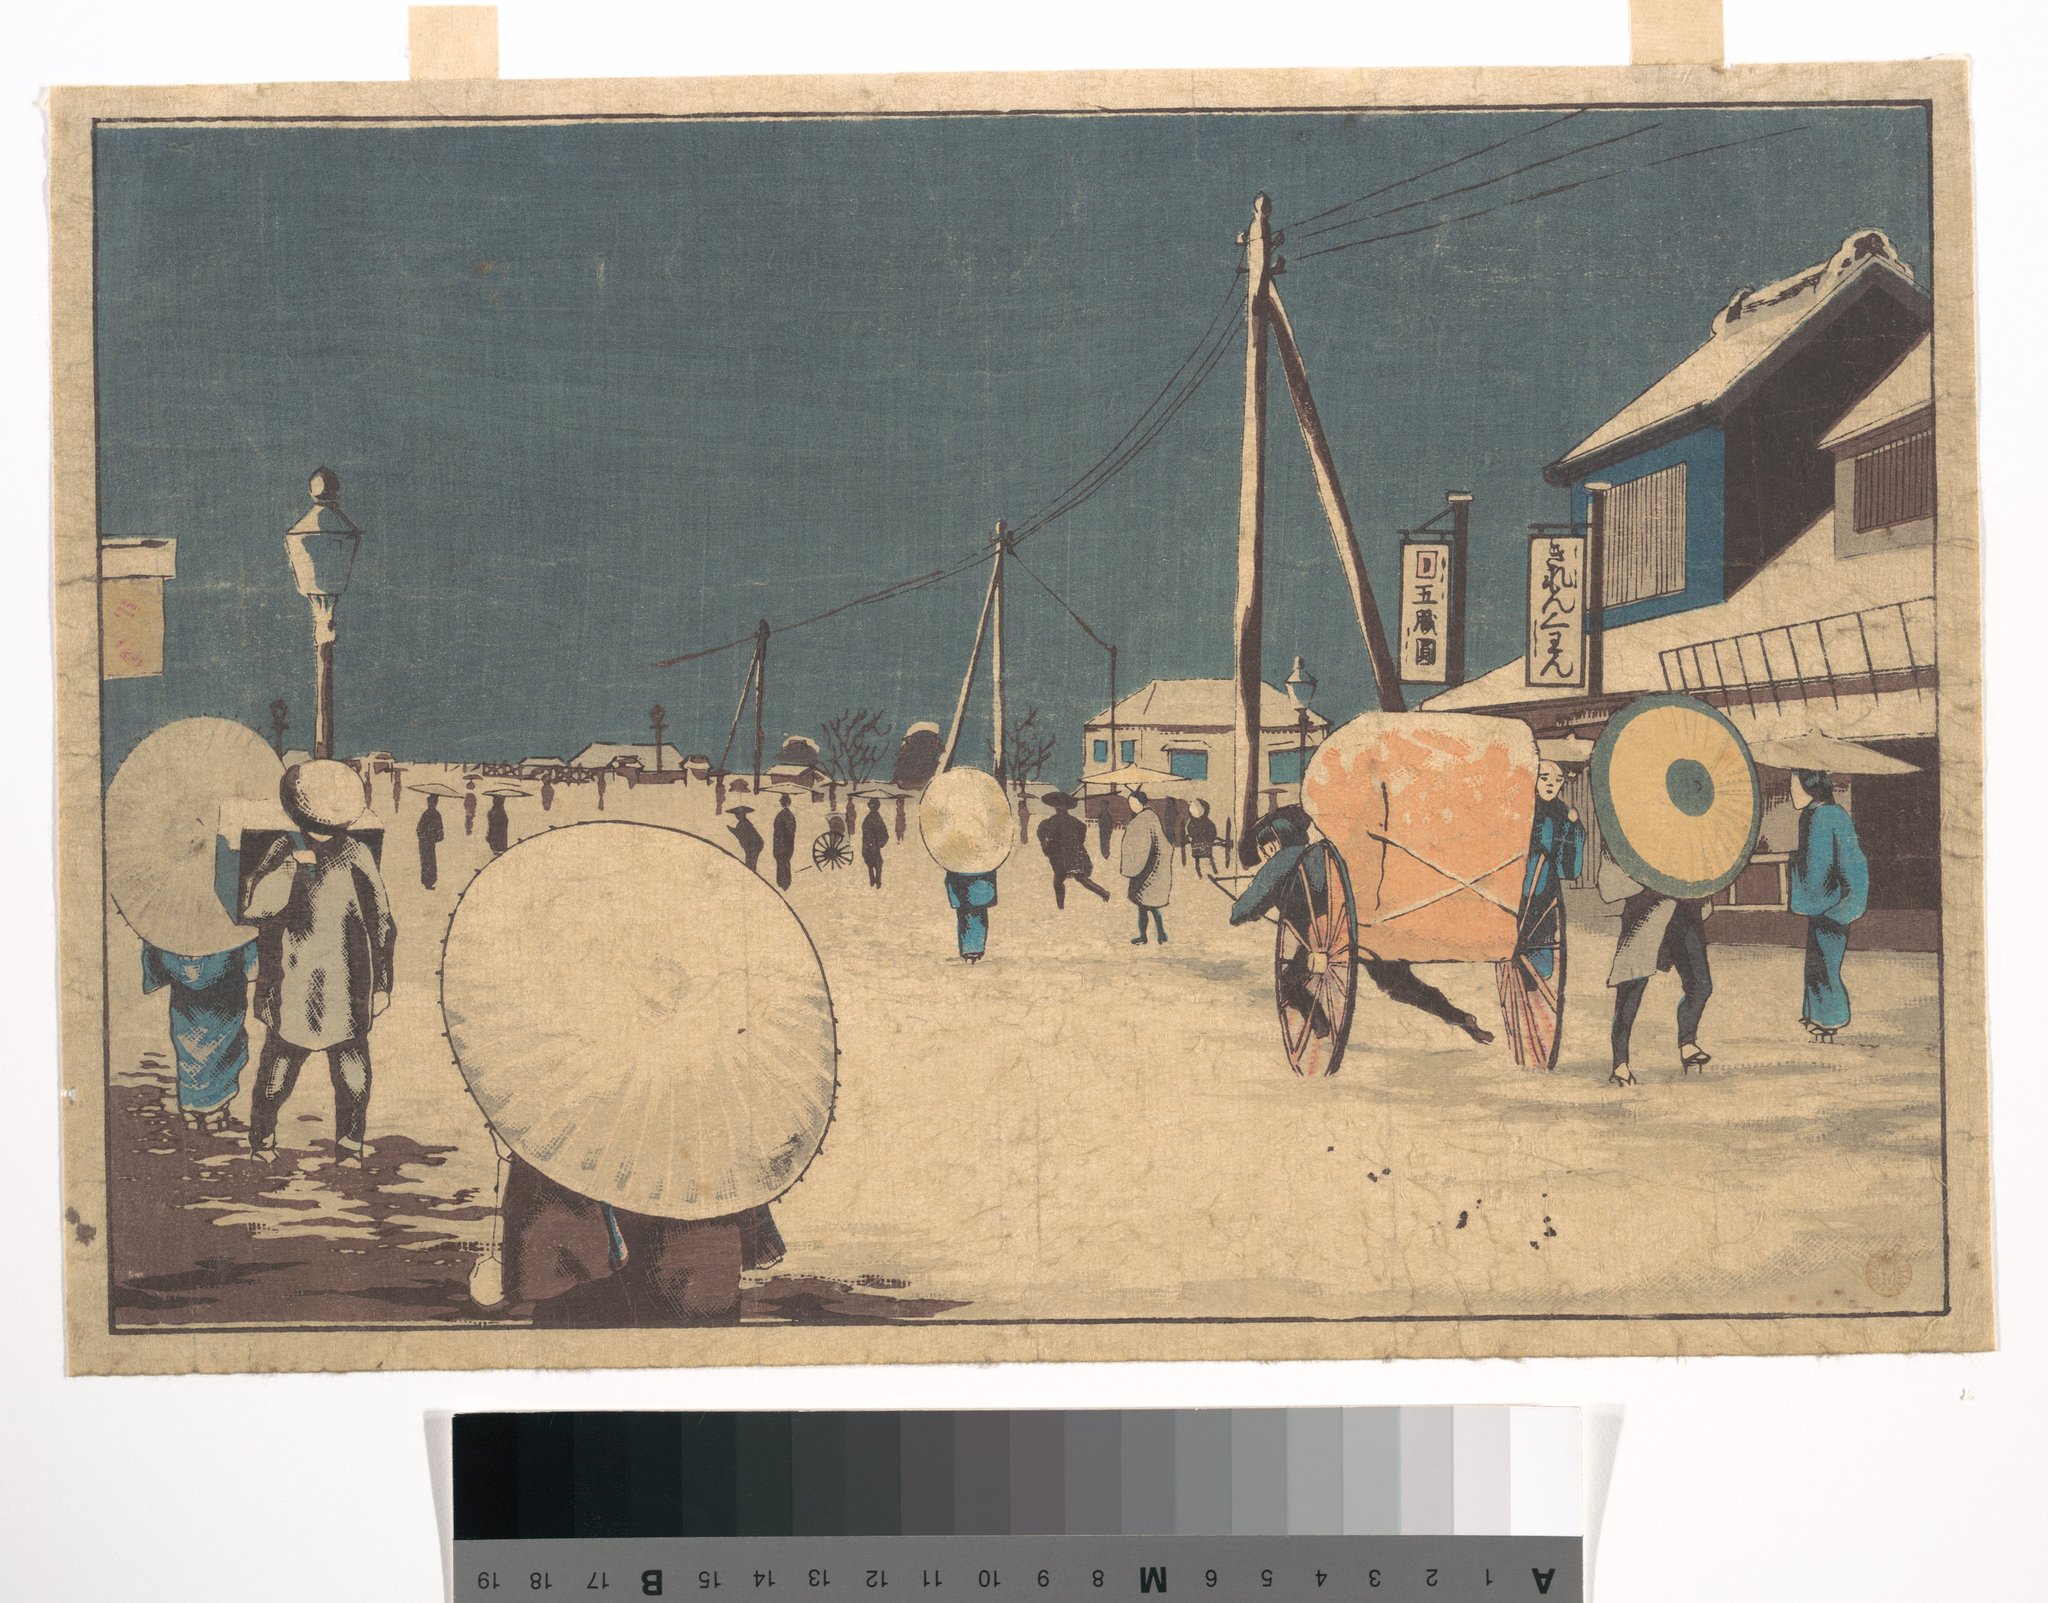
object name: print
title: Street Scene in the Outskirts of Edo on an Evening in Winter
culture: japanese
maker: kobayashi kiyochika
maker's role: artist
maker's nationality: japanese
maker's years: 1847-1915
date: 1878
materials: ink, paper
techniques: woodblock print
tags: human figures,houses,streets,carriages